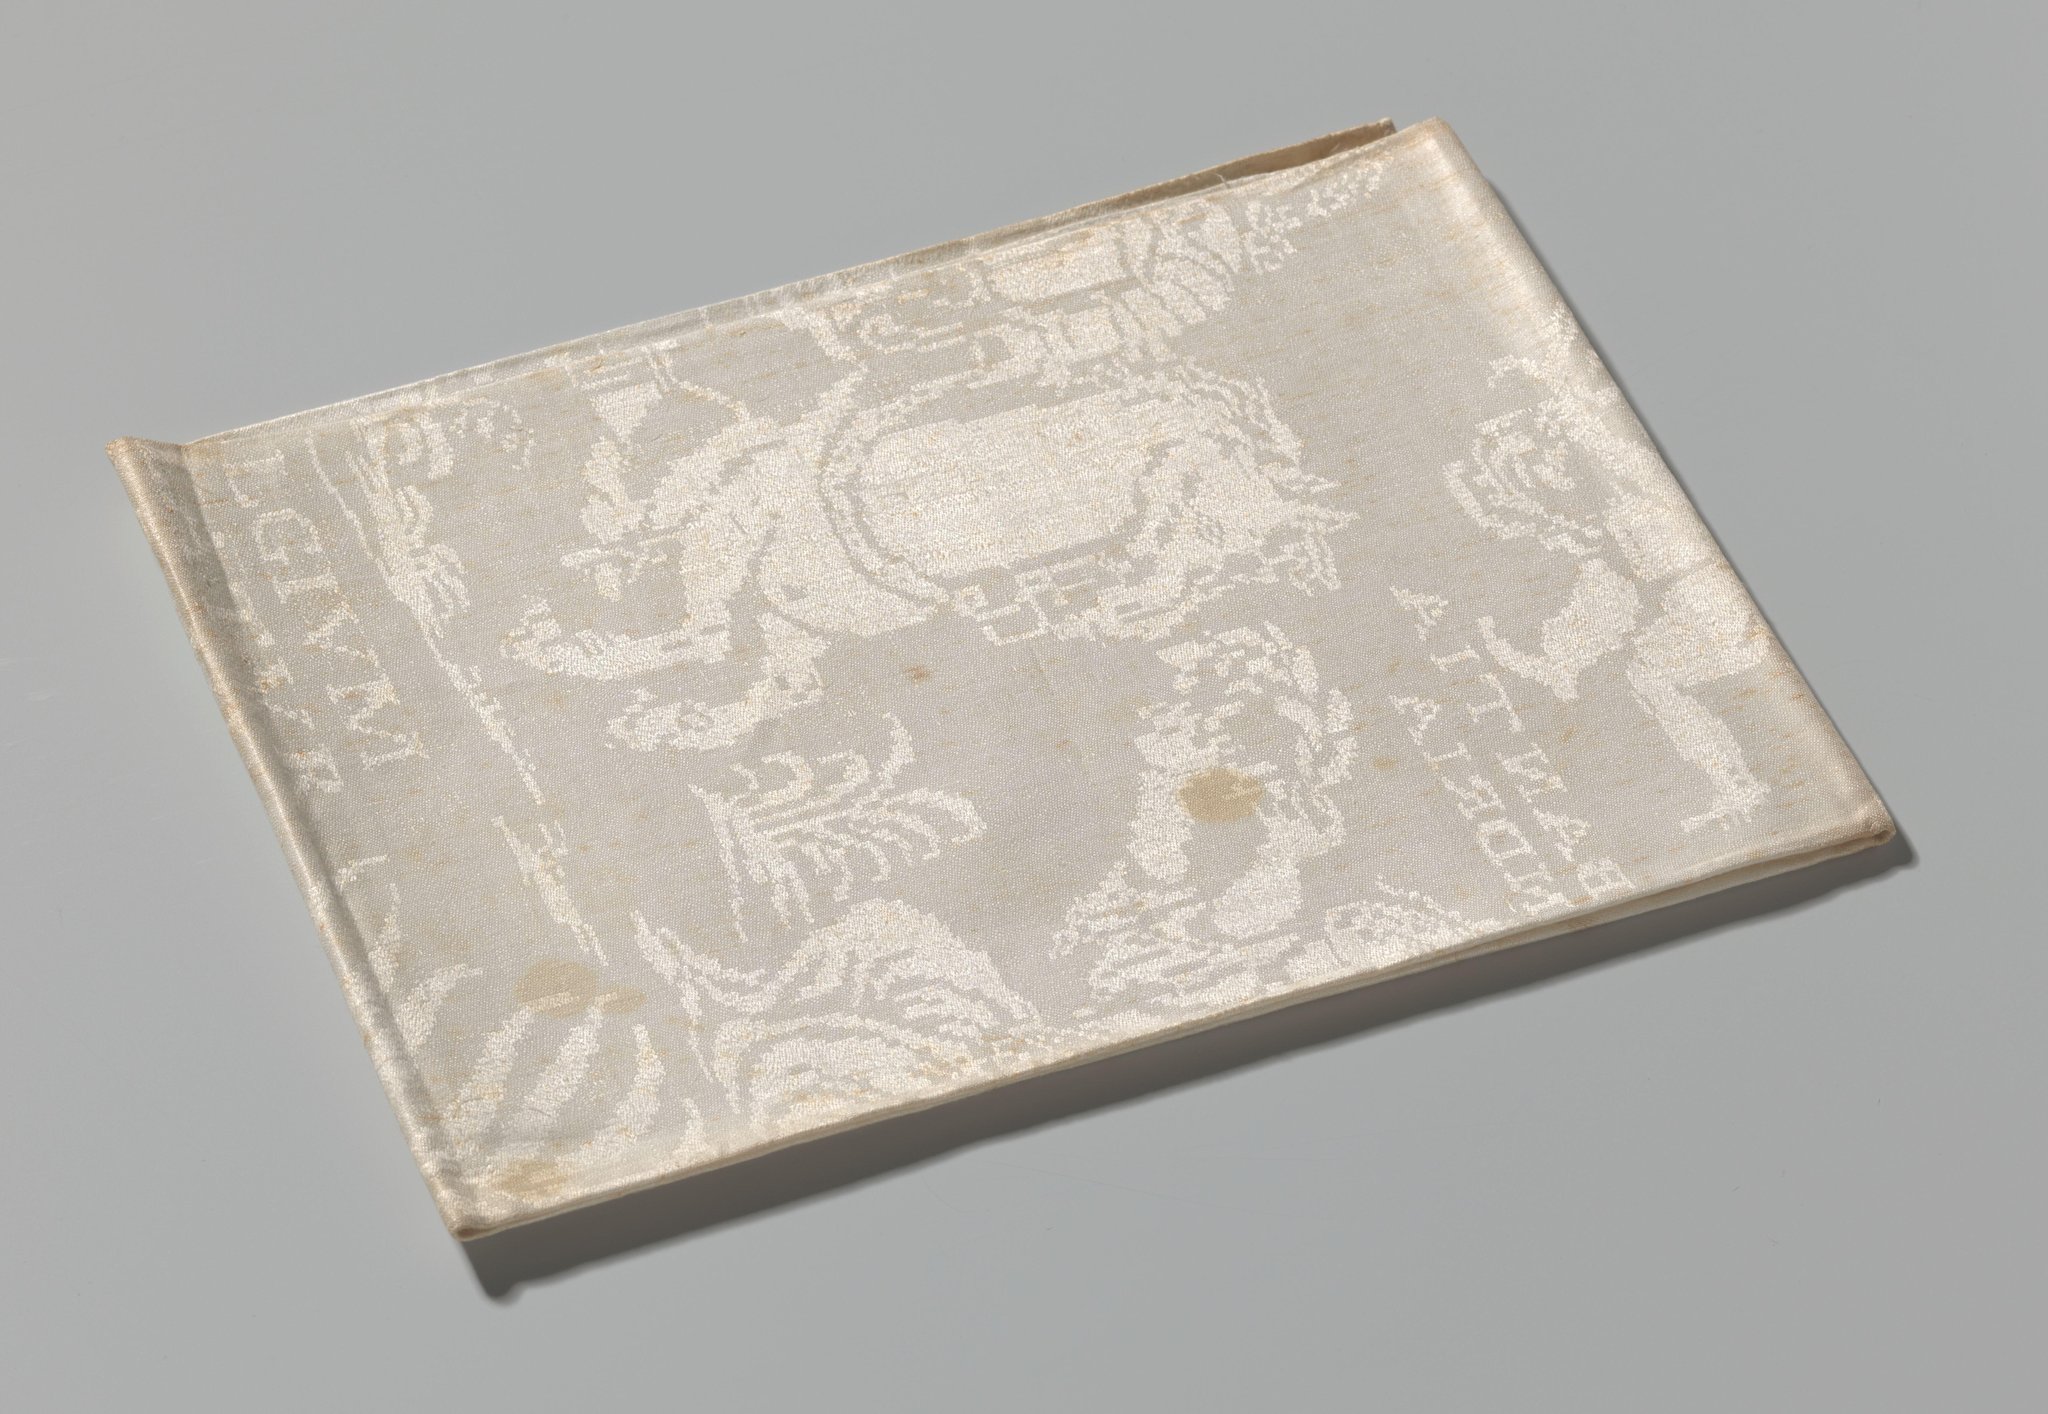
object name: napkin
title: Servet van linnendamast met de verheerlijking van Karel VI van Habsburg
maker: Anonymous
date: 1711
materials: linen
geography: flanders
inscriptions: number: ‘12’, mark: ‘TZ’, mark: ‘BB’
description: Wit linnendamasten servet met de verheerlijking van Karel VI van Habsburg.